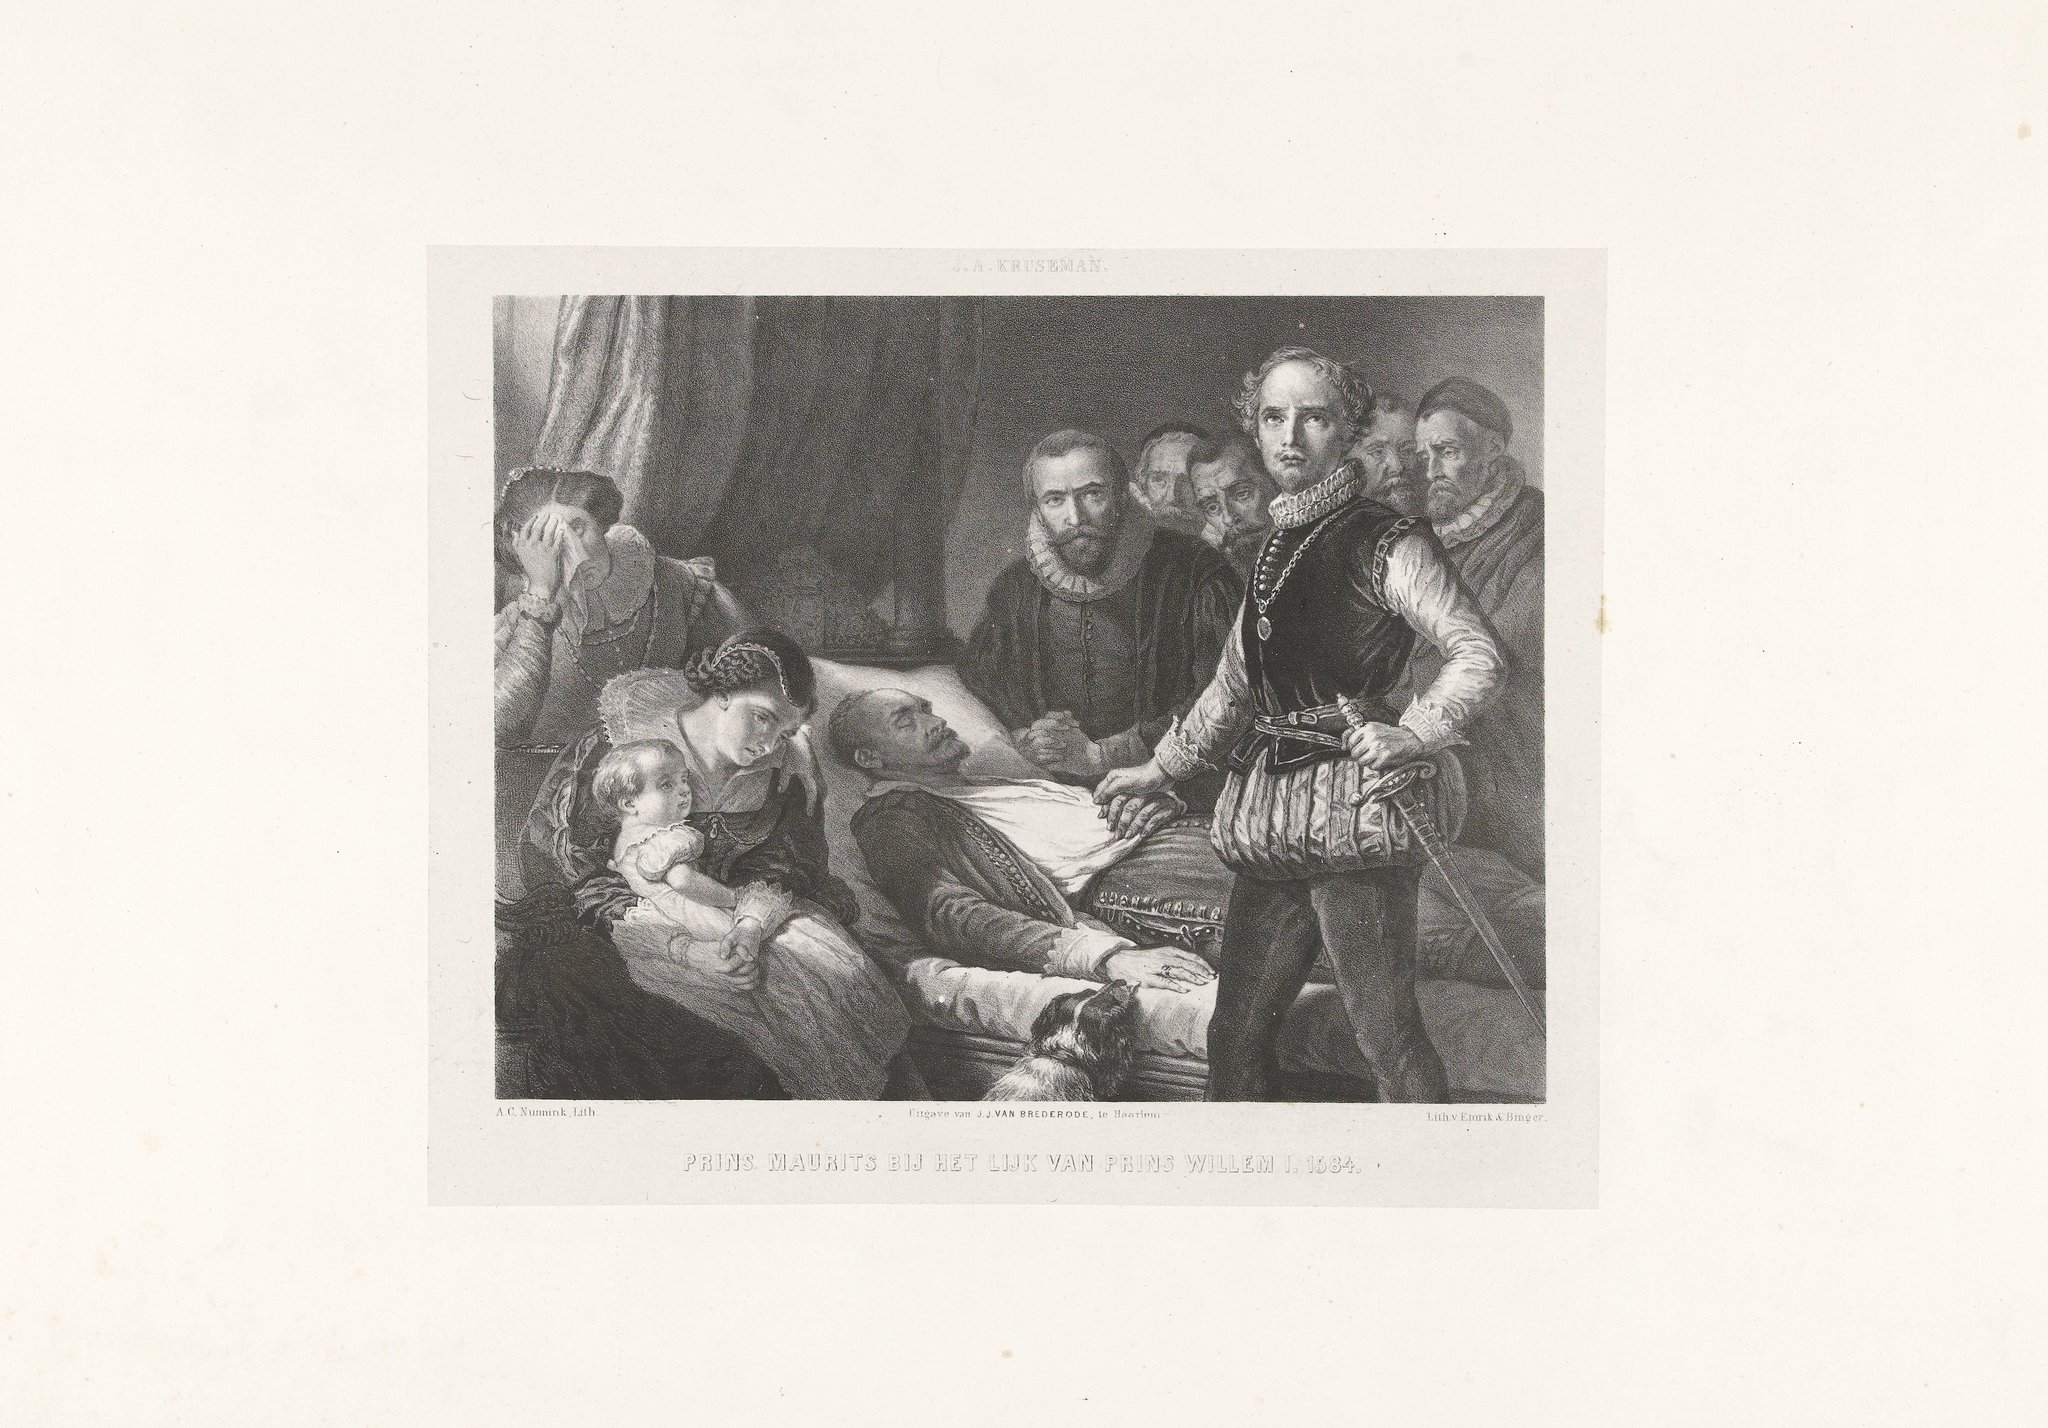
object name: history print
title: Maurits bij het lichaam van Willem van Oranje, 1584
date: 1856-1860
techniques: printmaking, lithograph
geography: netherlands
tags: louise de coligny, frederick henry (prince of orange), delft, william i (prince of orange), the hague, maurice (prince of orange), deathbed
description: Naar het schilderij gedateerd 1856. De prent komt ook voor in: Bladzijden uit de geschiedenis van Neêrlands roem en grootheid, Haarlem [1860], bij een gedicht van A. Beeloo.